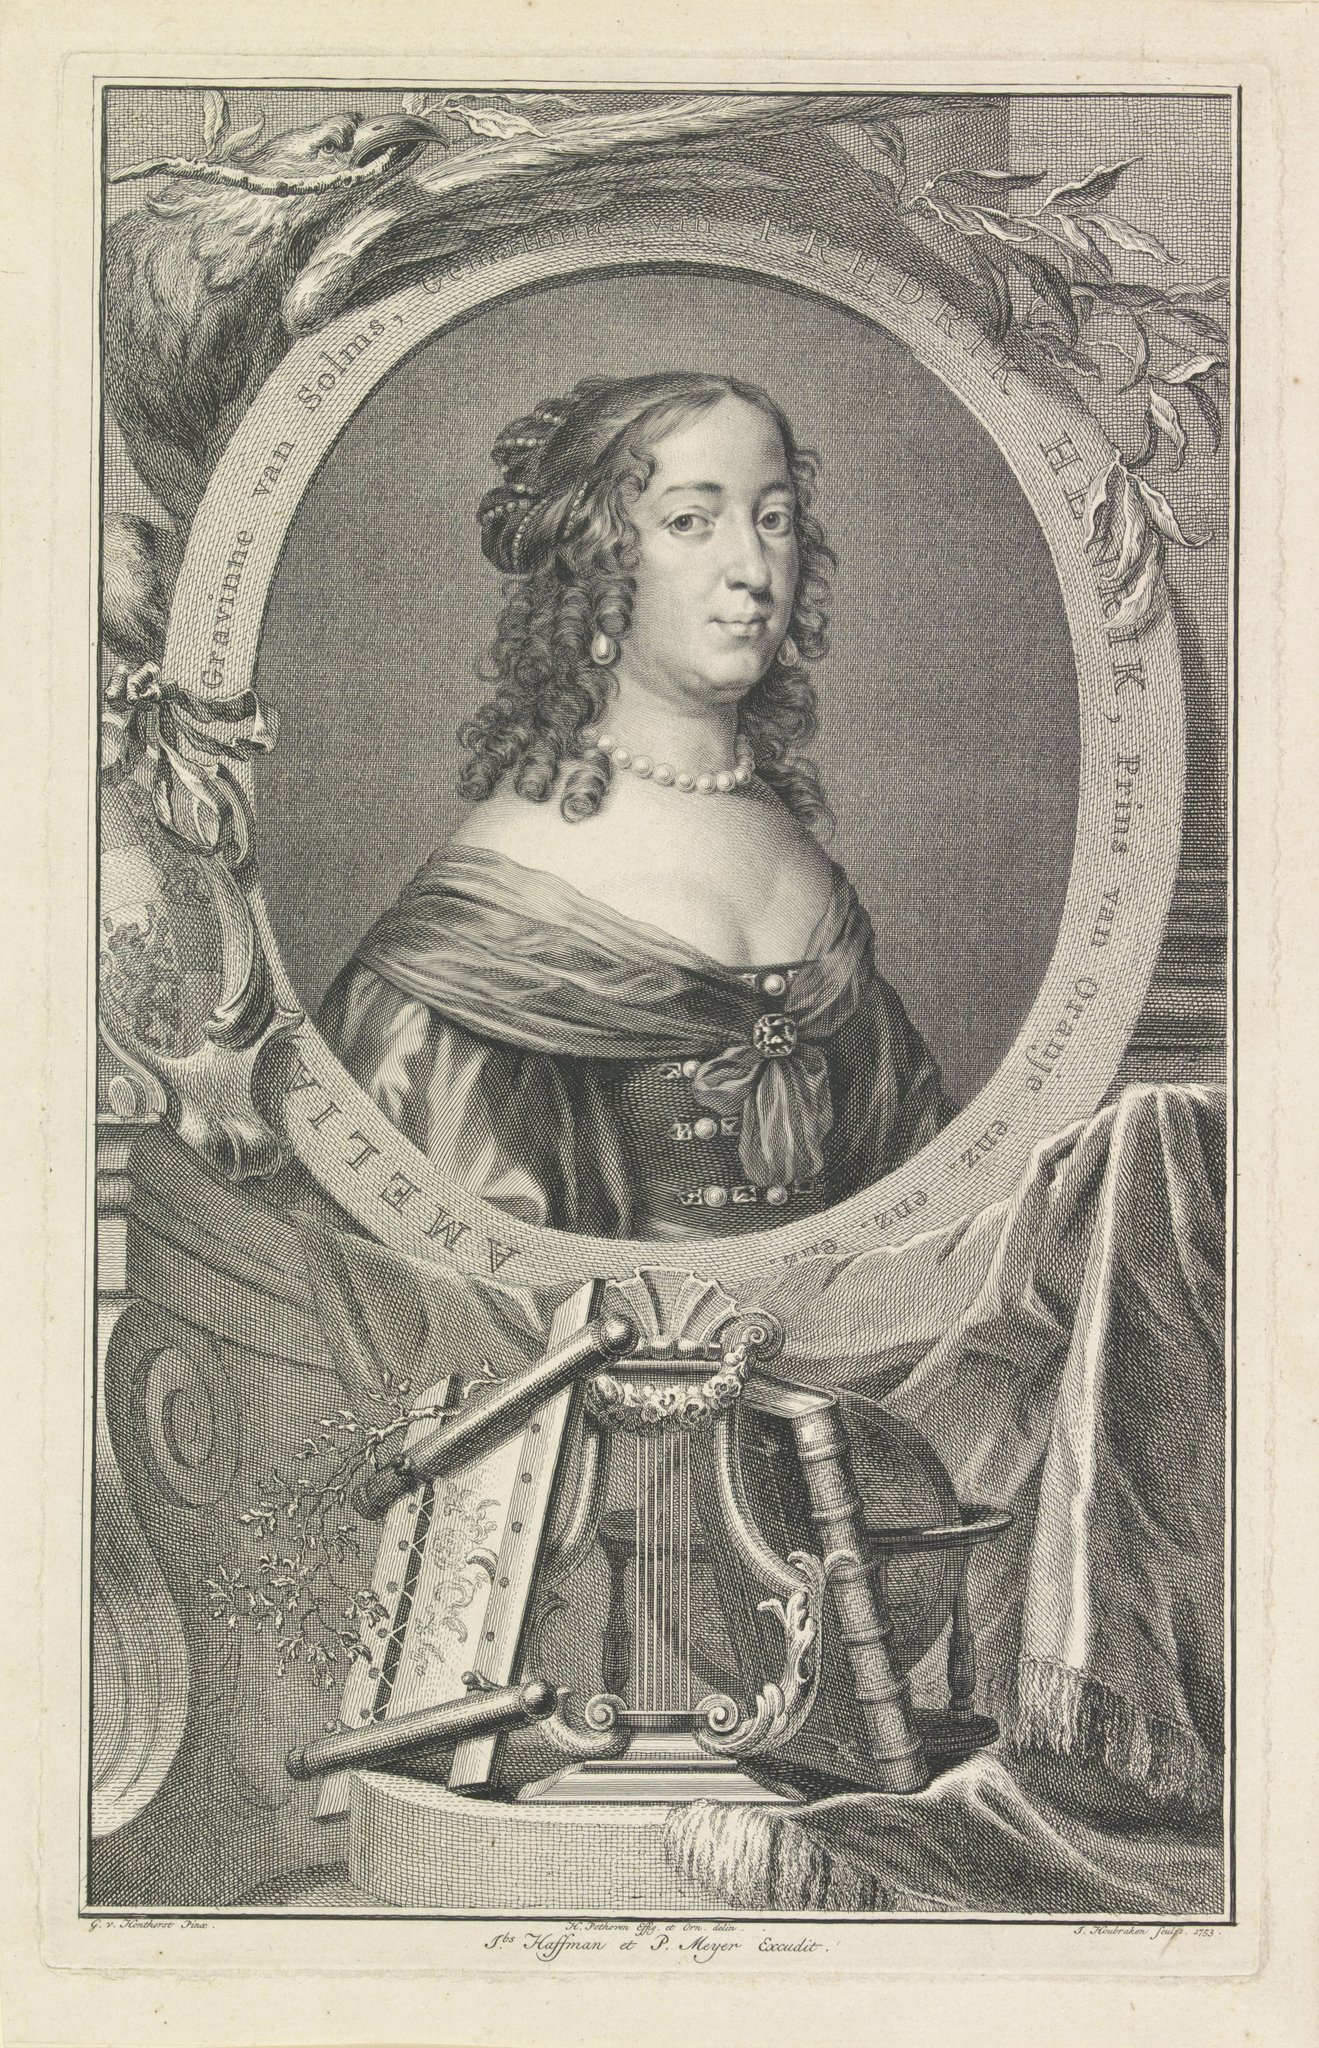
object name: print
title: Portret van Amalia van Solms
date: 1753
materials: paper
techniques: engraving, etching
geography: amsterdam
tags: amalia of solms-braunfels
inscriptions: collector's mark: Lugt 963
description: Portret van Amalia in een ovaal met randschrift. Rondom ligt een aantal allegorische objecten.